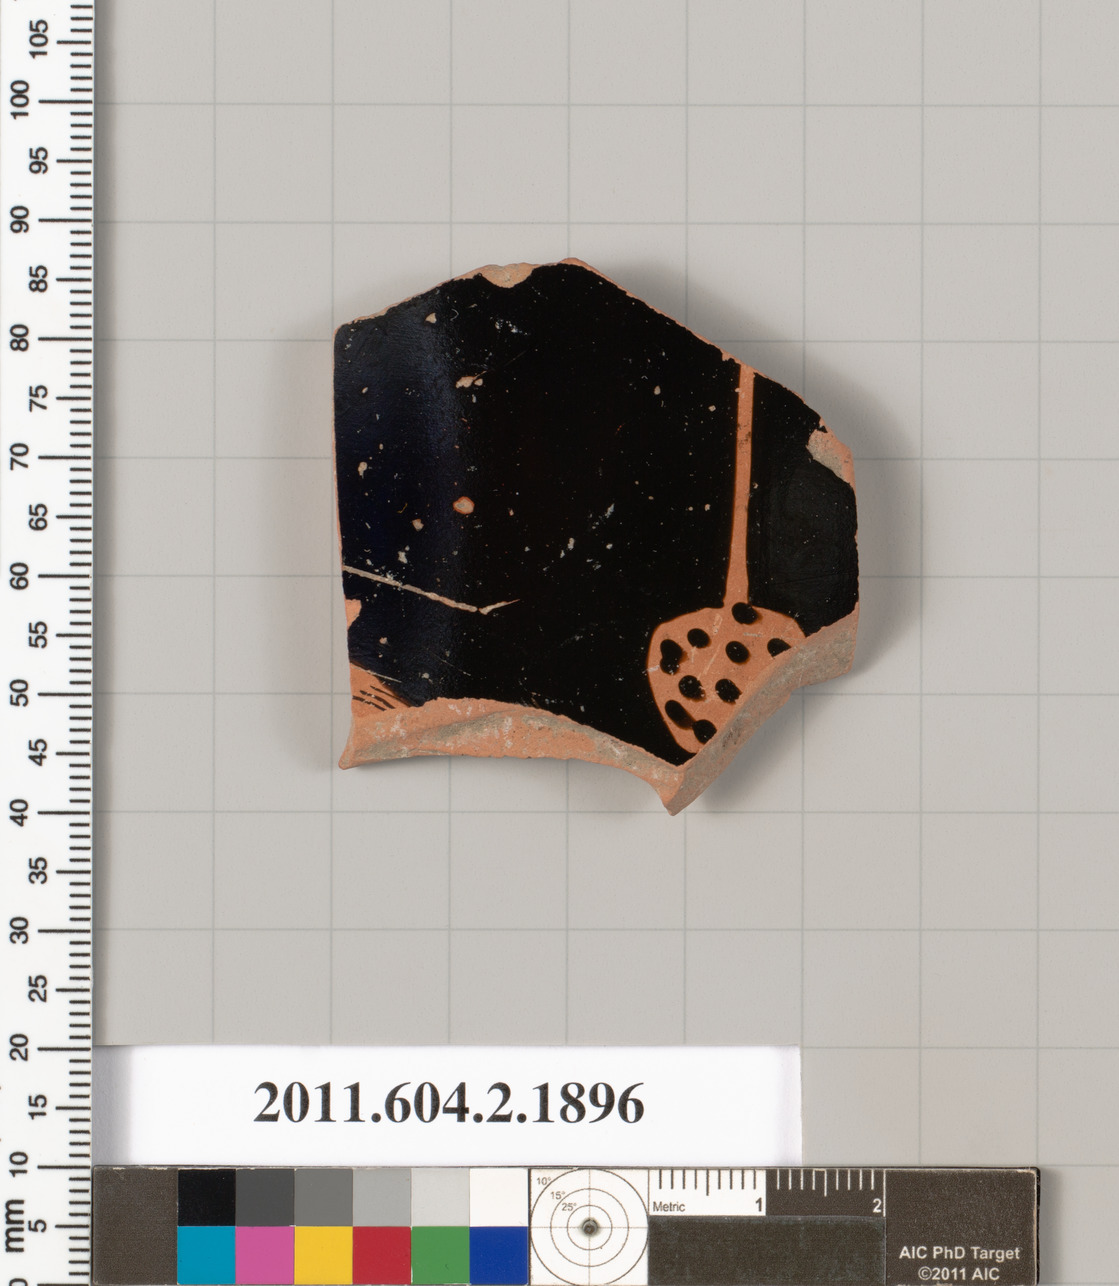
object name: skyphos fragment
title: Terracotta fragment of a skyphos (deep drinking cup)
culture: greek, attic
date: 430-400 BCE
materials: terracotta